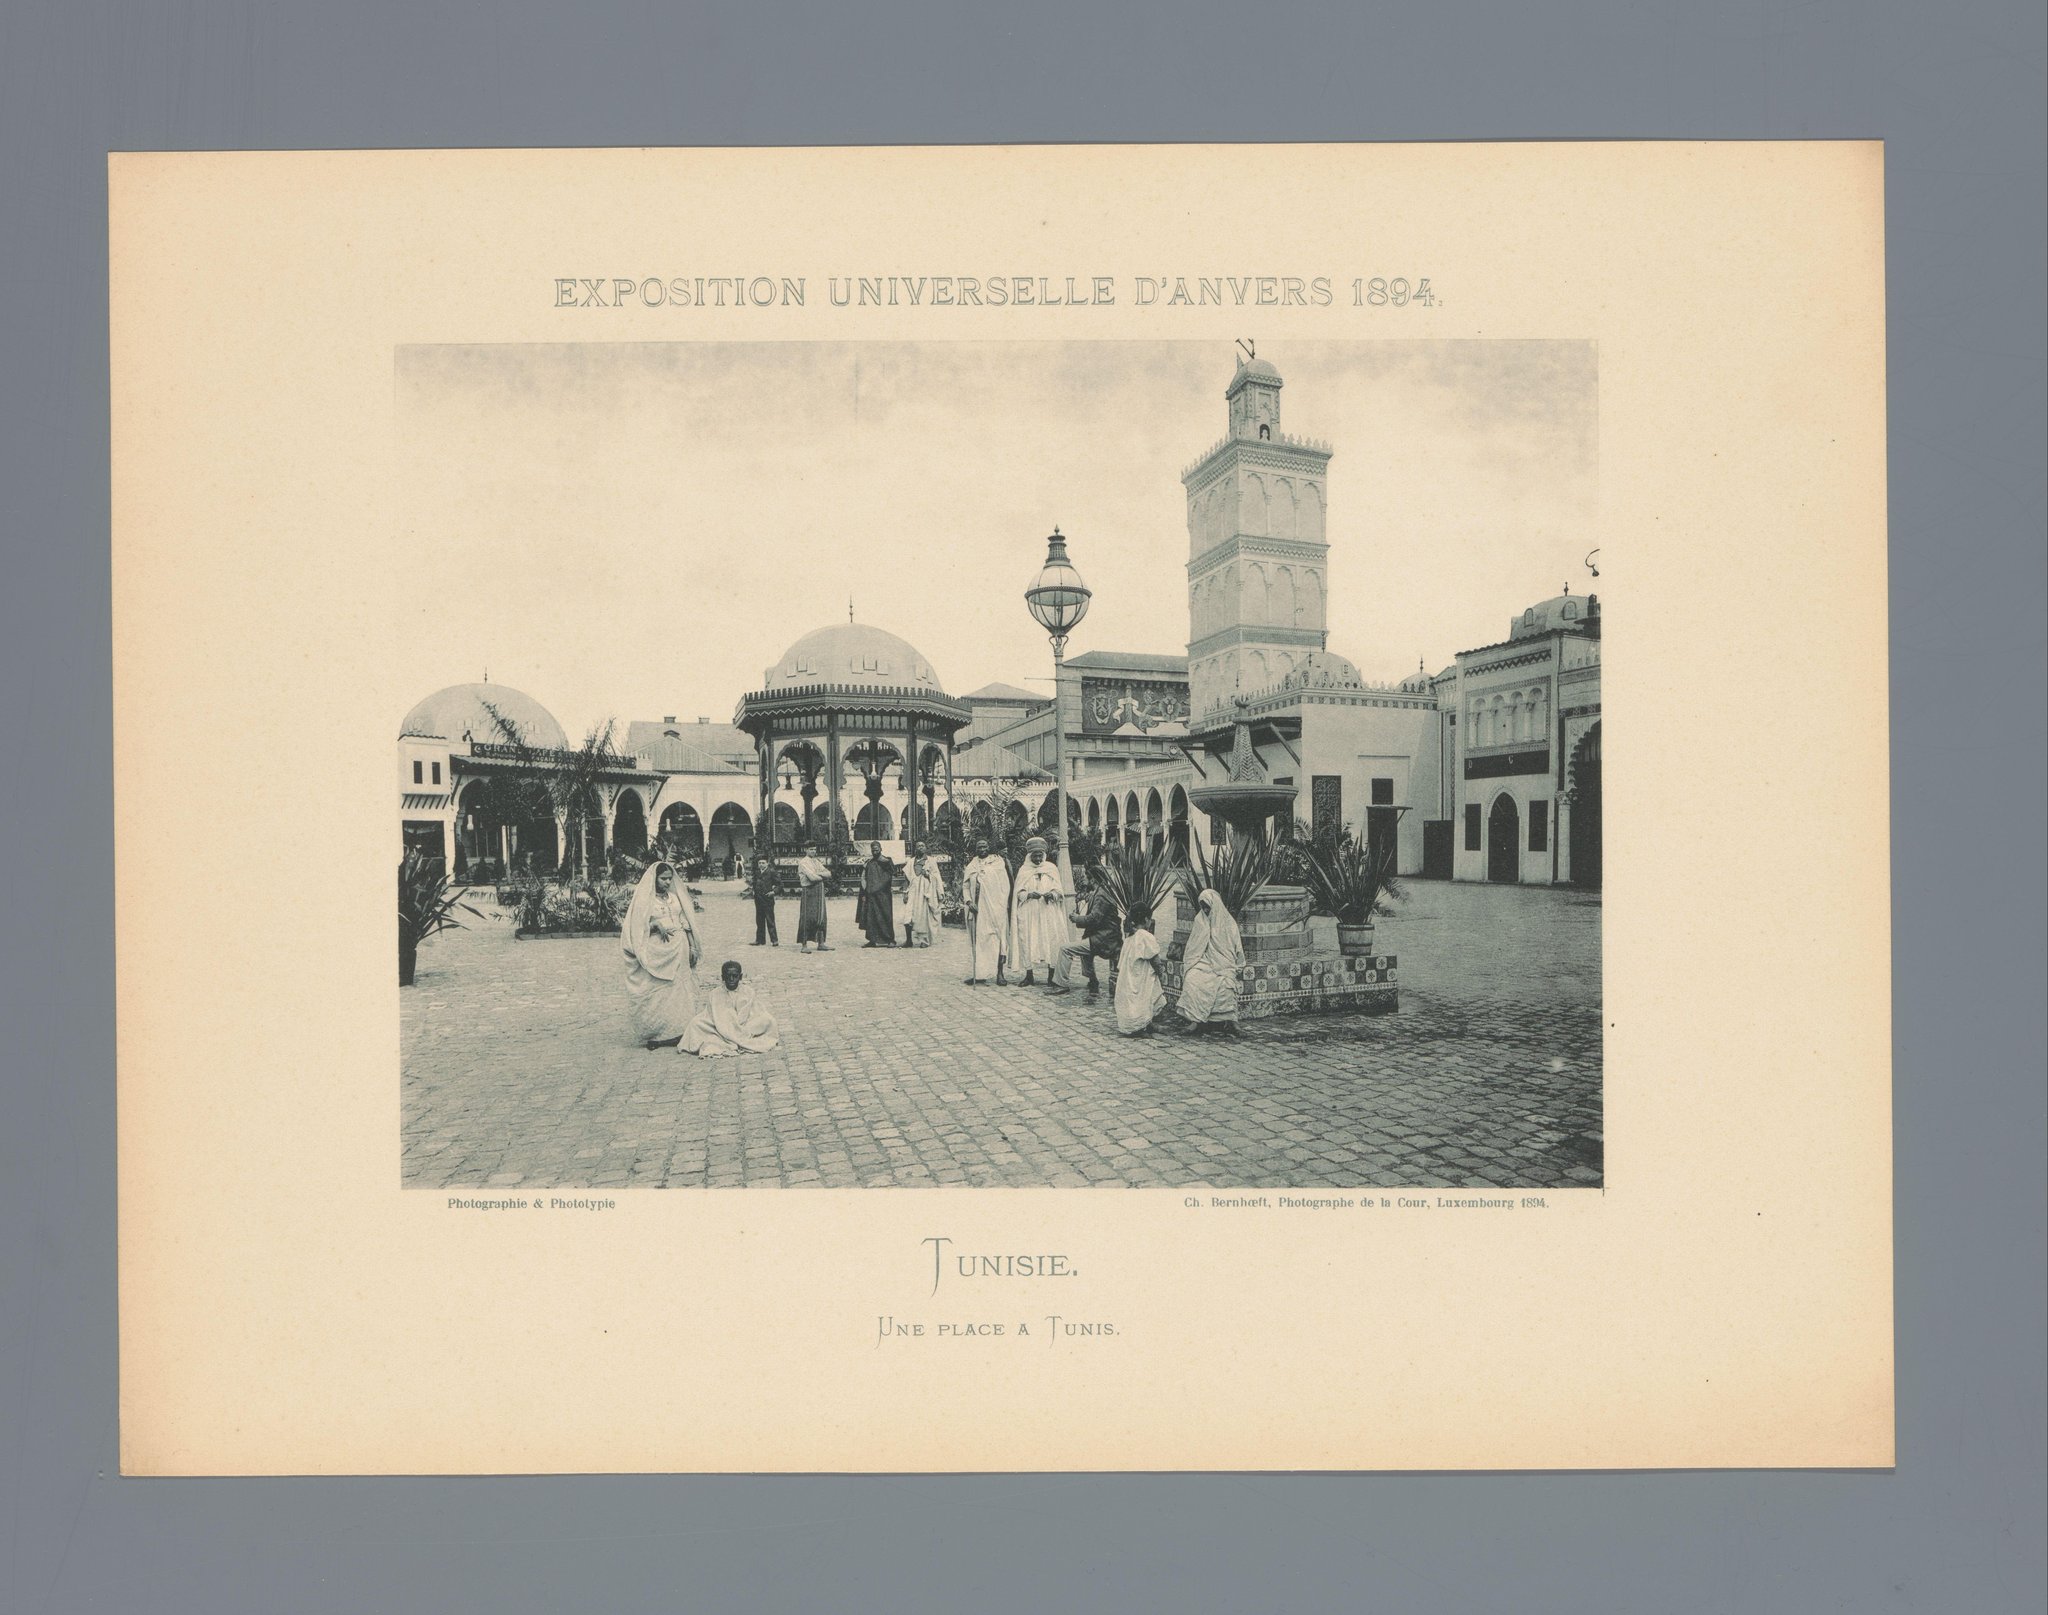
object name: photomechanical print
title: Onbekende personen bij de Tunesische afdeling tijdens de Wereldtentoonstelling van 1894 te Antwerpen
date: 1894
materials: paper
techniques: photograph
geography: antwerp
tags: world fair, world exhibition, historical persons, asiatic races and peoples (with name), antwerp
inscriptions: inscription: ‘Exposition Universelle D'Anvers 1894’